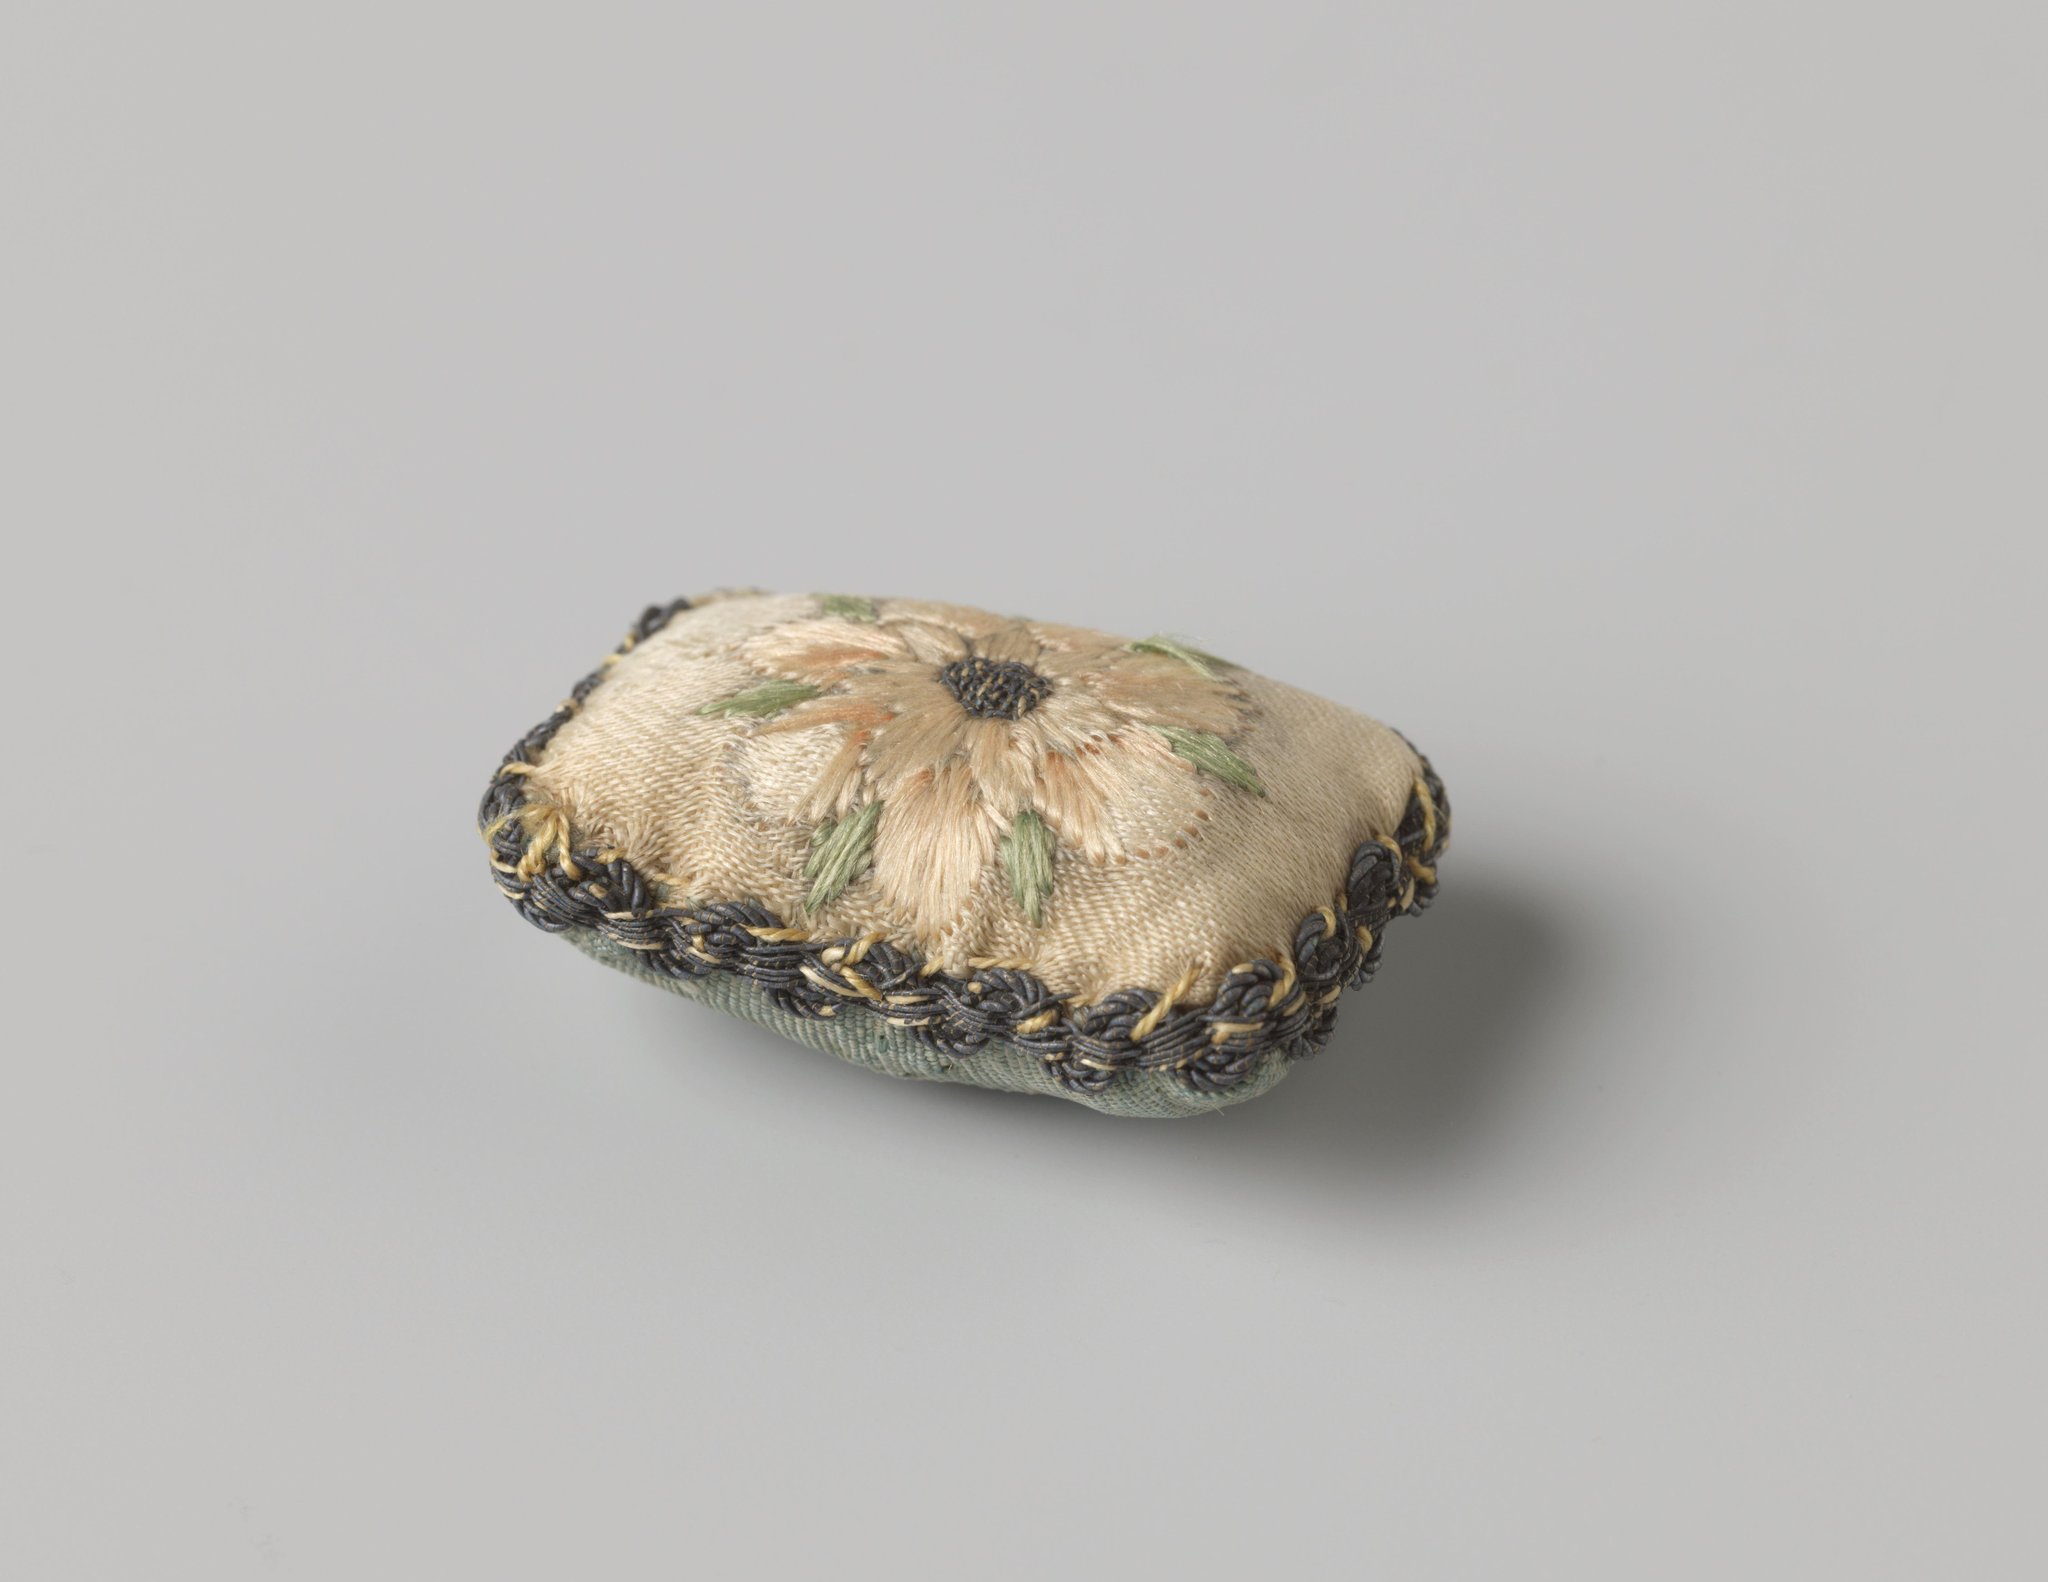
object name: miniature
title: Speldenkussen, met op de bovenzijde geborduurd een roze bloem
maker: Anonymous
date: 1750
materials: metal thread, silk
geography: amsterdam